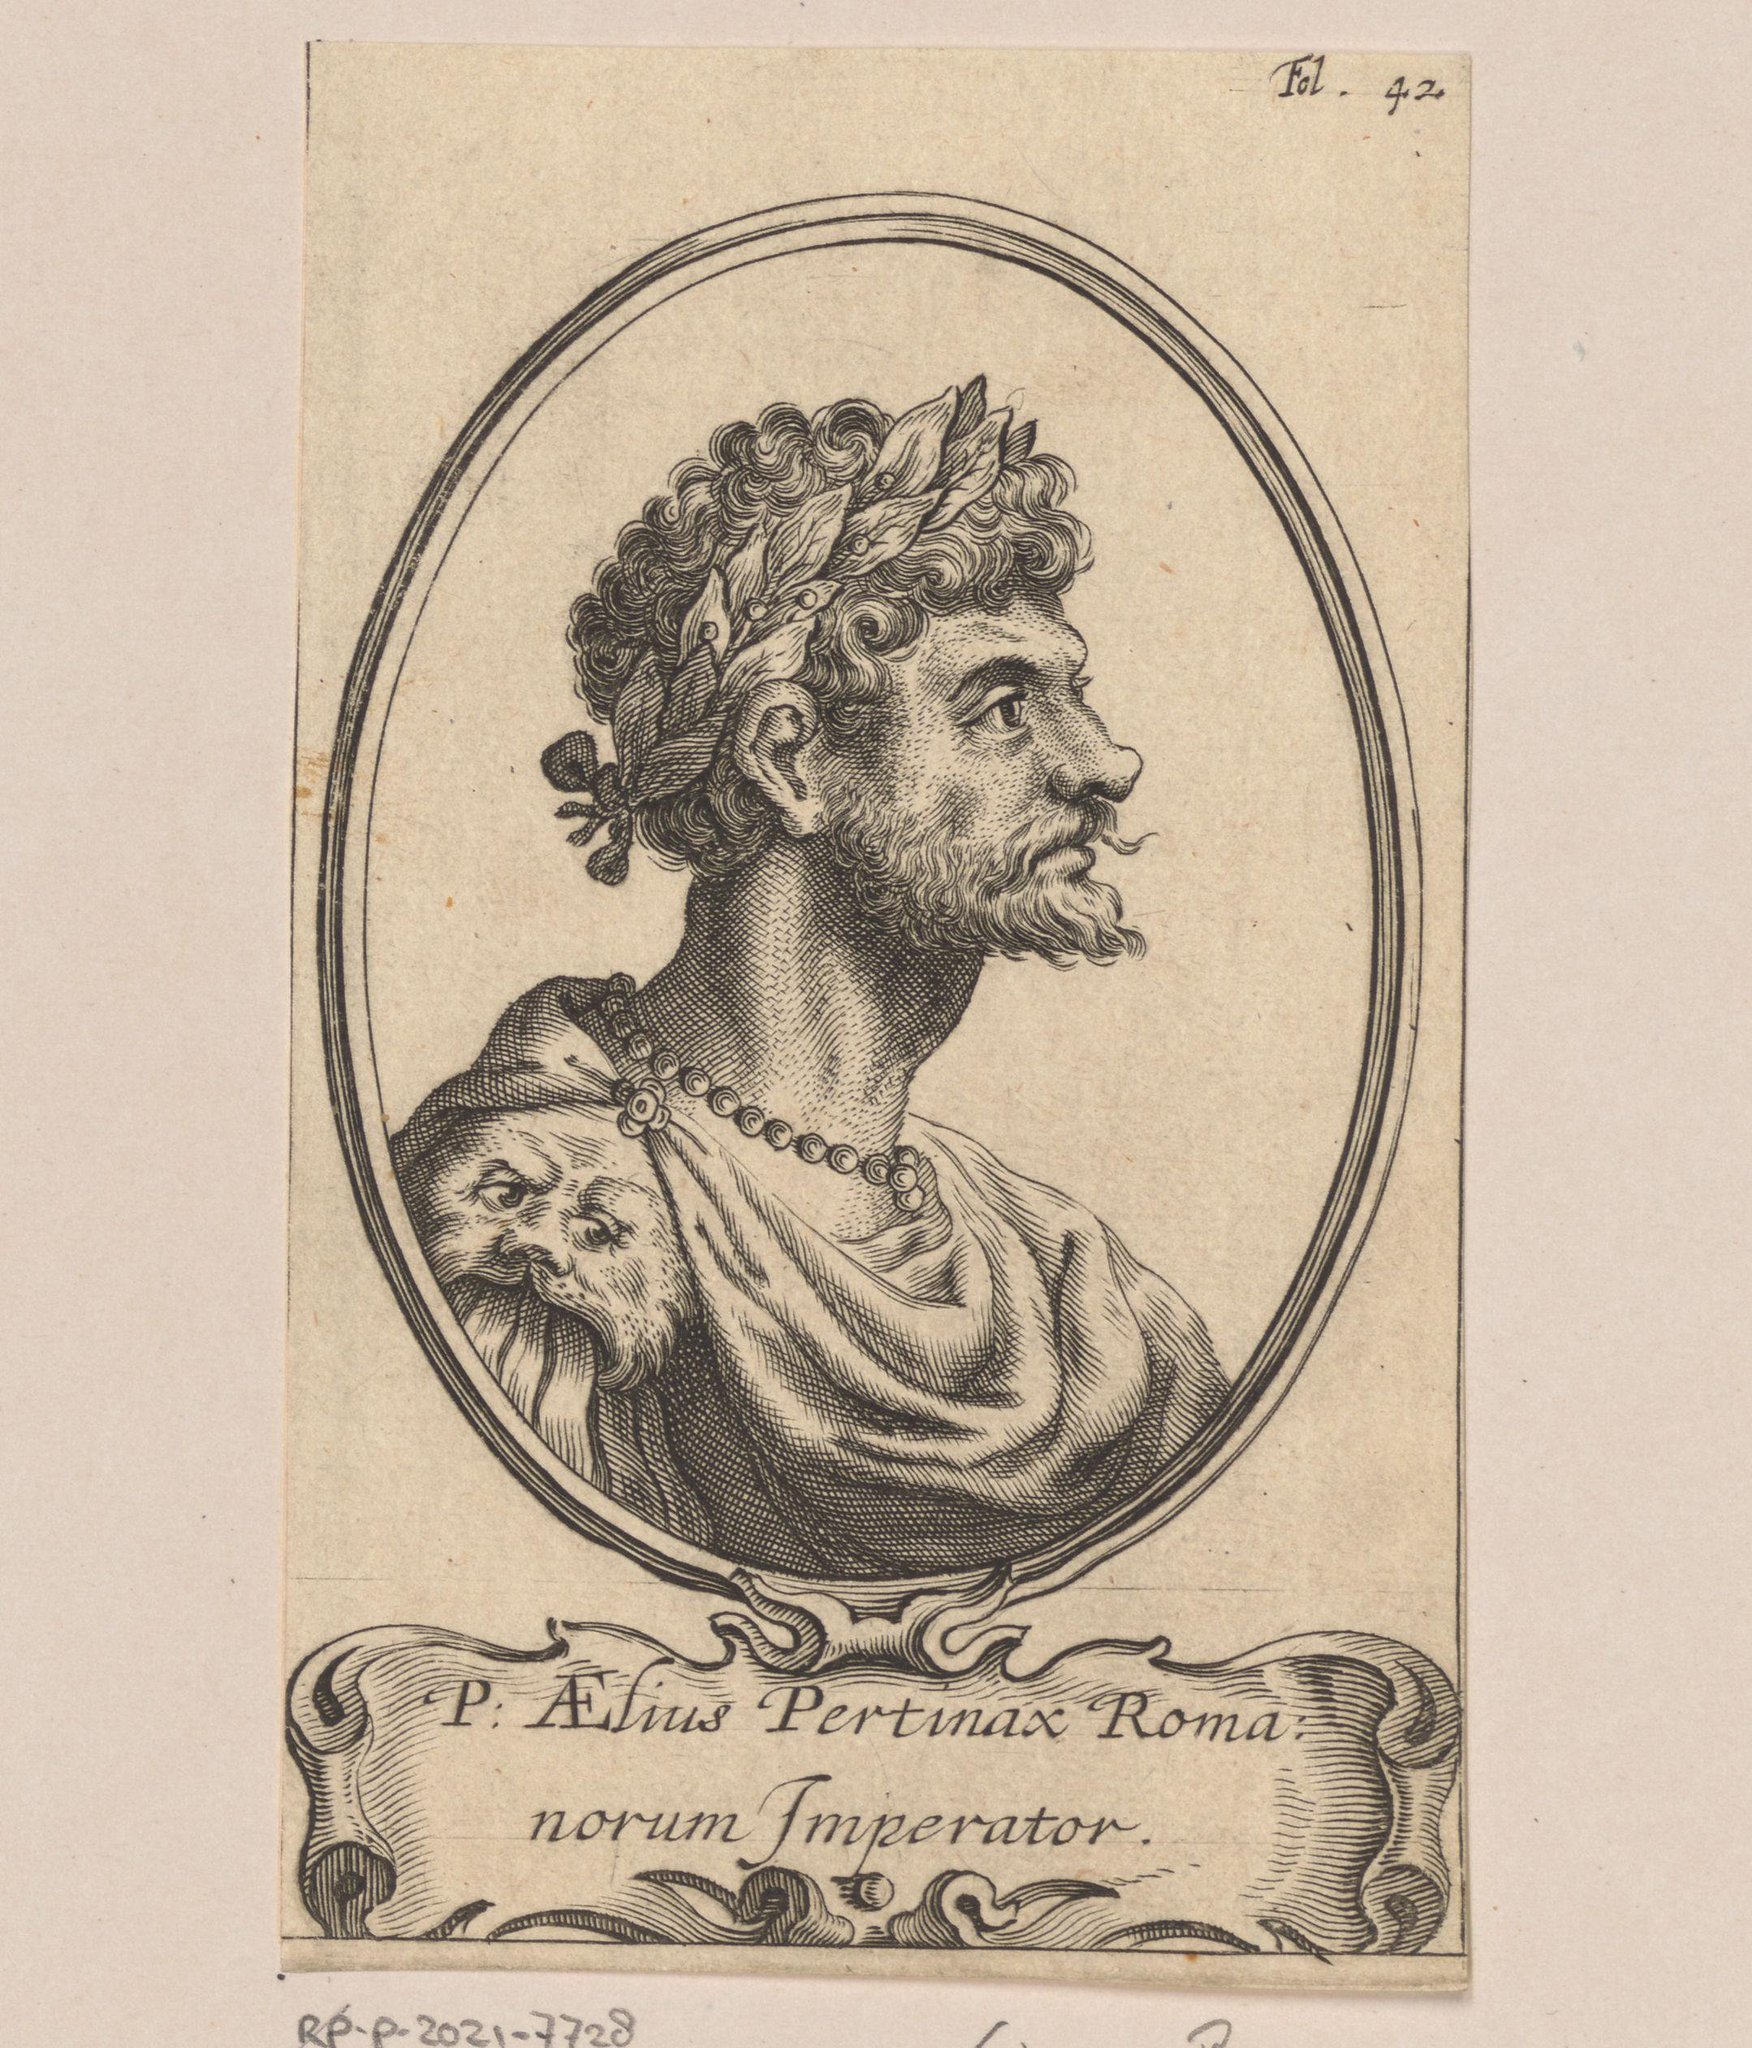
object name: book illustration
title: Portret van Pertinax, keizer van het Romeinse Rijk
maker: Anonymous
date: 1656-1659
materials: paper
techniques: engraving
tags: adult man, historical persons, emperor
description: Prent uit: Bos, Lambert van den. Het konincklyk treur-toonneel, ofte op- en ondergangh der keyseren, koningen en vorsten (...). Dordrecht: Jacobus Savry, 1656. Of uit de editie van 1659.